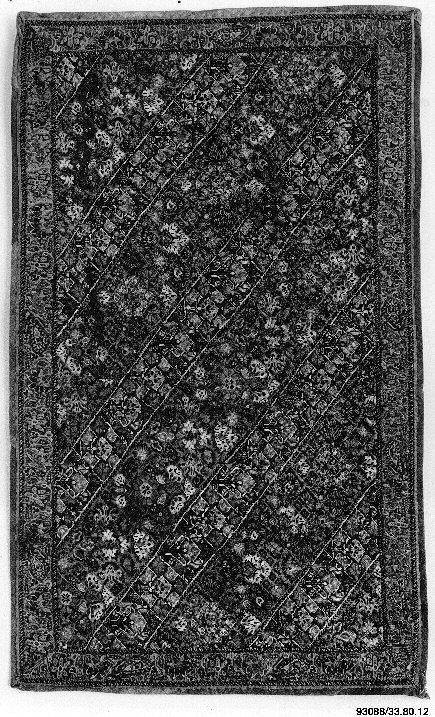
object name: trousering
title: Woman's Trousering (Nakshe)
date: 1701-1800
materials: cotton, silk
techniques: embroidery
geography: iran